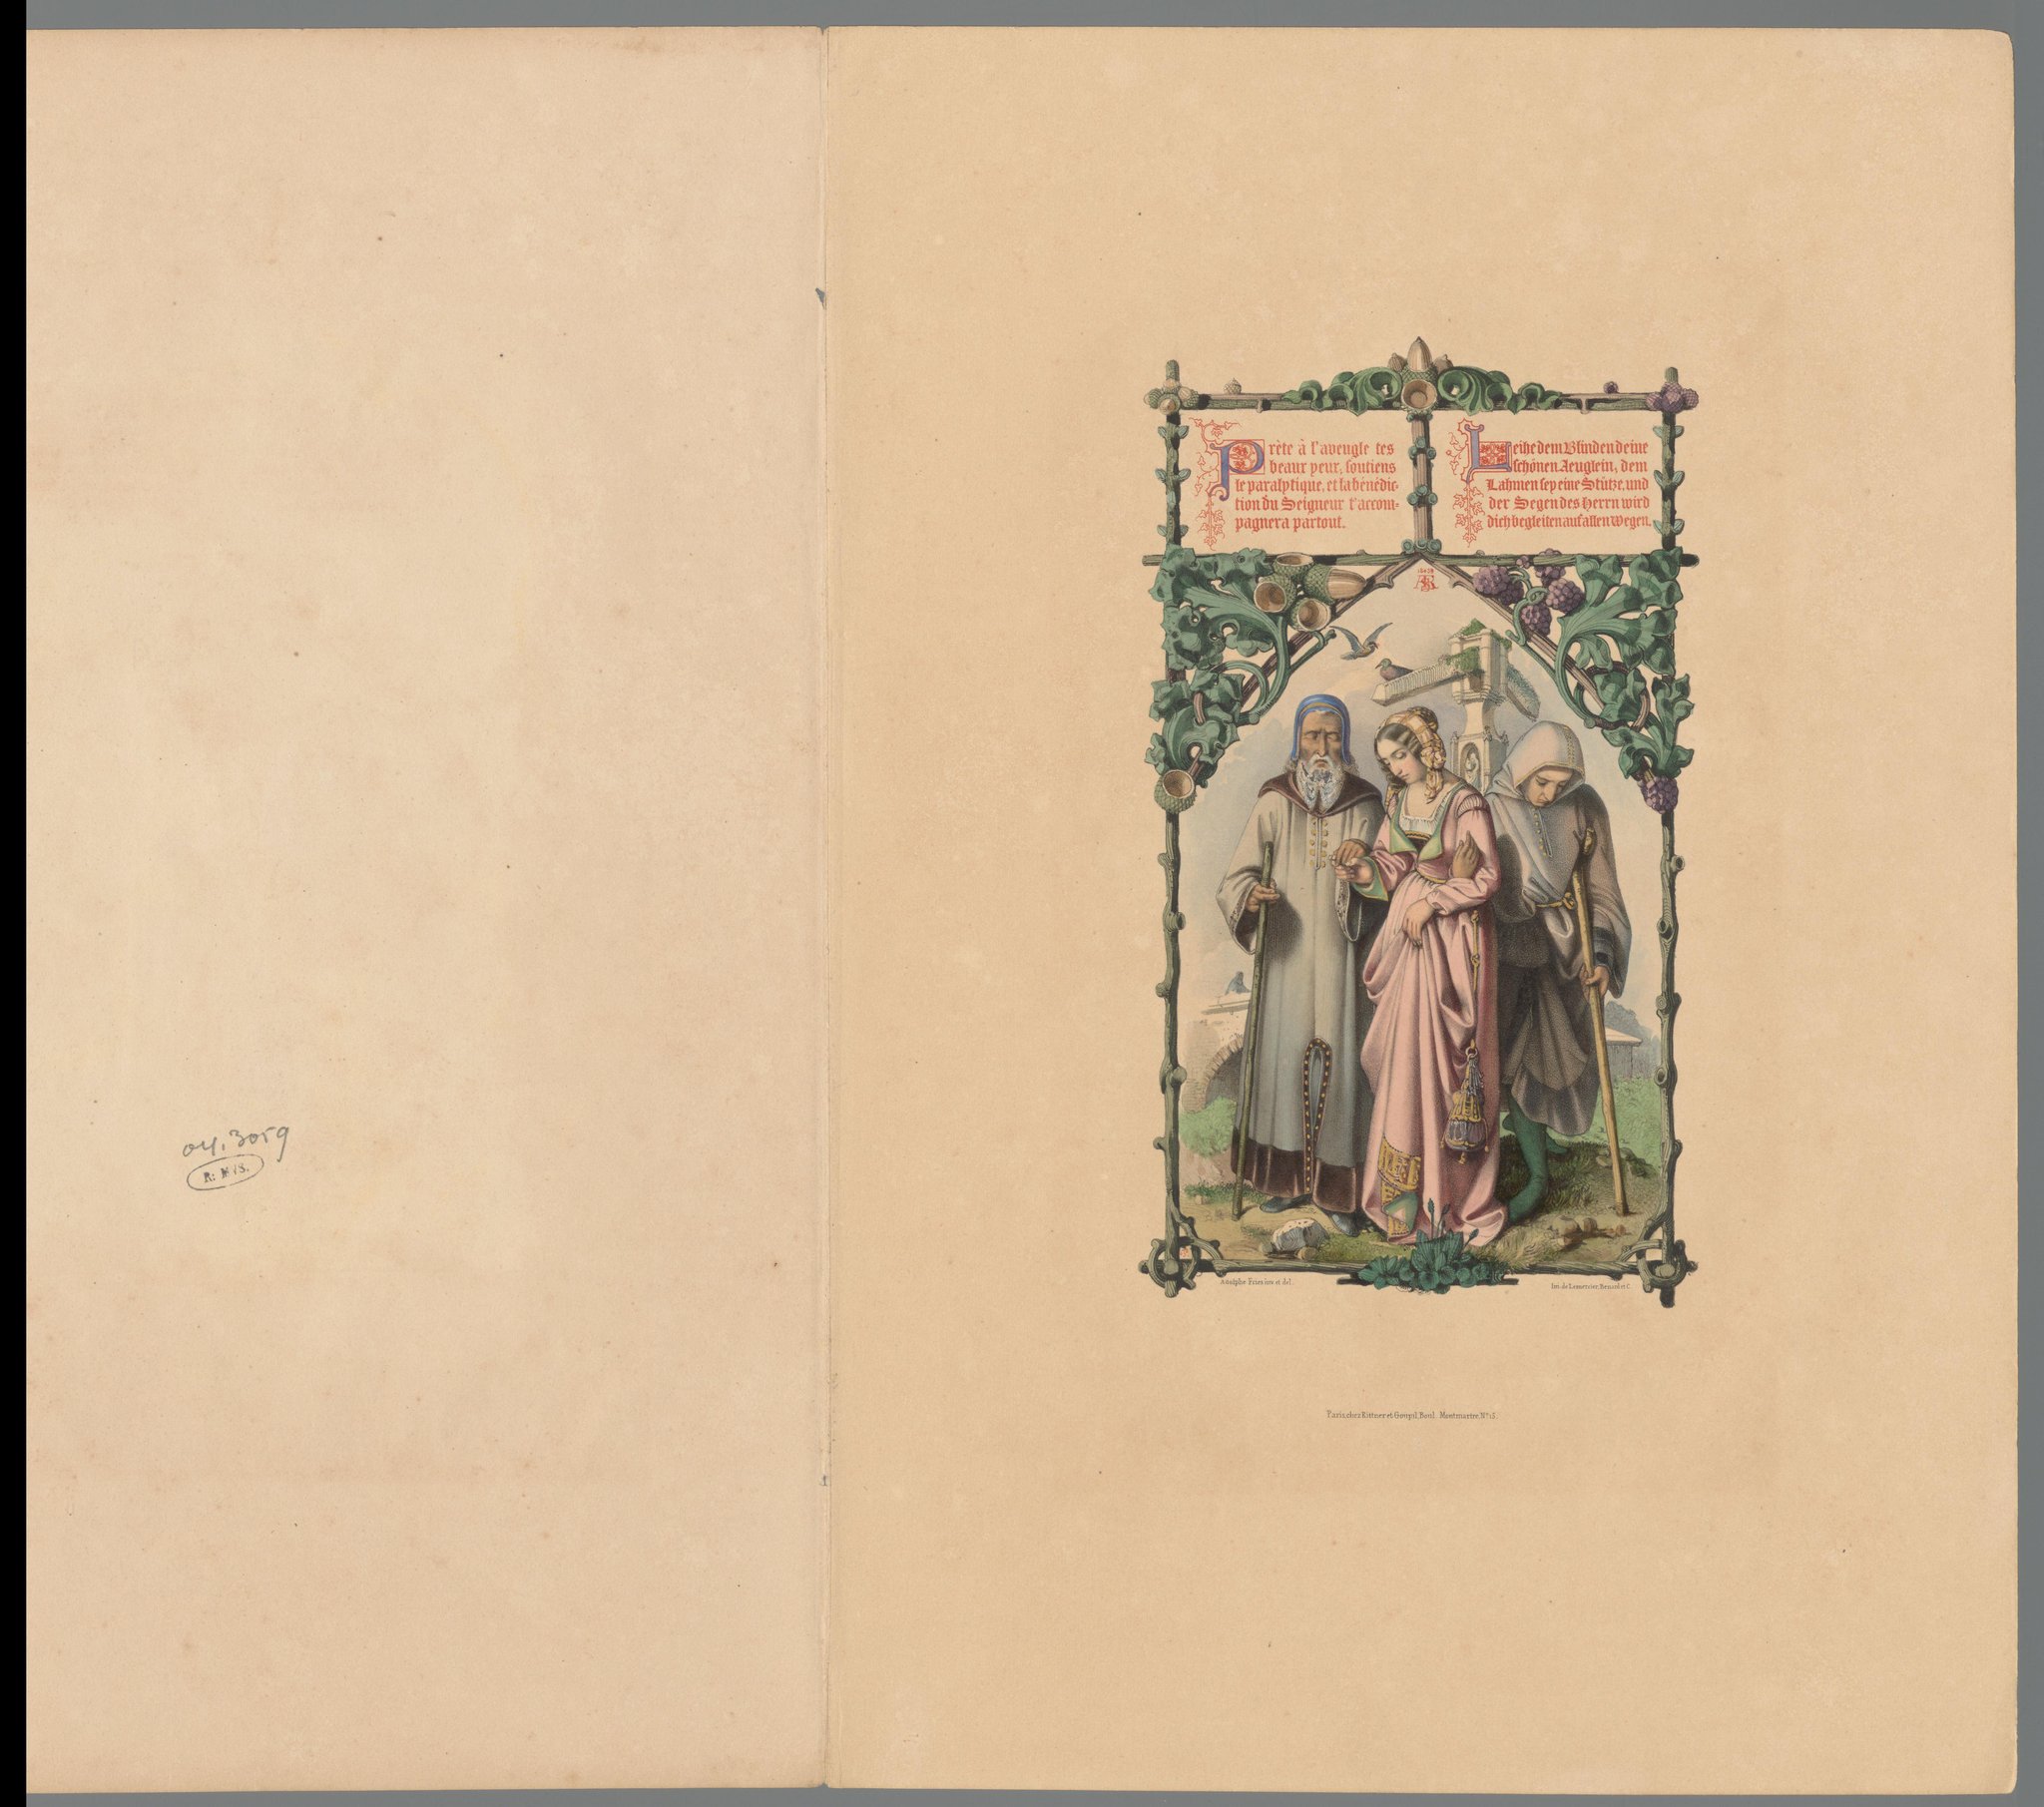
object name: print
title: Vrouw begeleidt twee blinde mannen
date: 1839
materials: paper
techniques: hand coloring, lithograph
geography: paris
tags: adult woman, adult man, blind, blindness, old man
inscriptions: collector's mark: Lugt 2228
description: Prent maakt deel uit van een serie met religieuze scènes. Over deze serie is verder niets bekend. Mogelijk is het een aanvulling op de eerder uitgegeven serie 'Paroles de l'âme' van Adolf Fries in 1837.